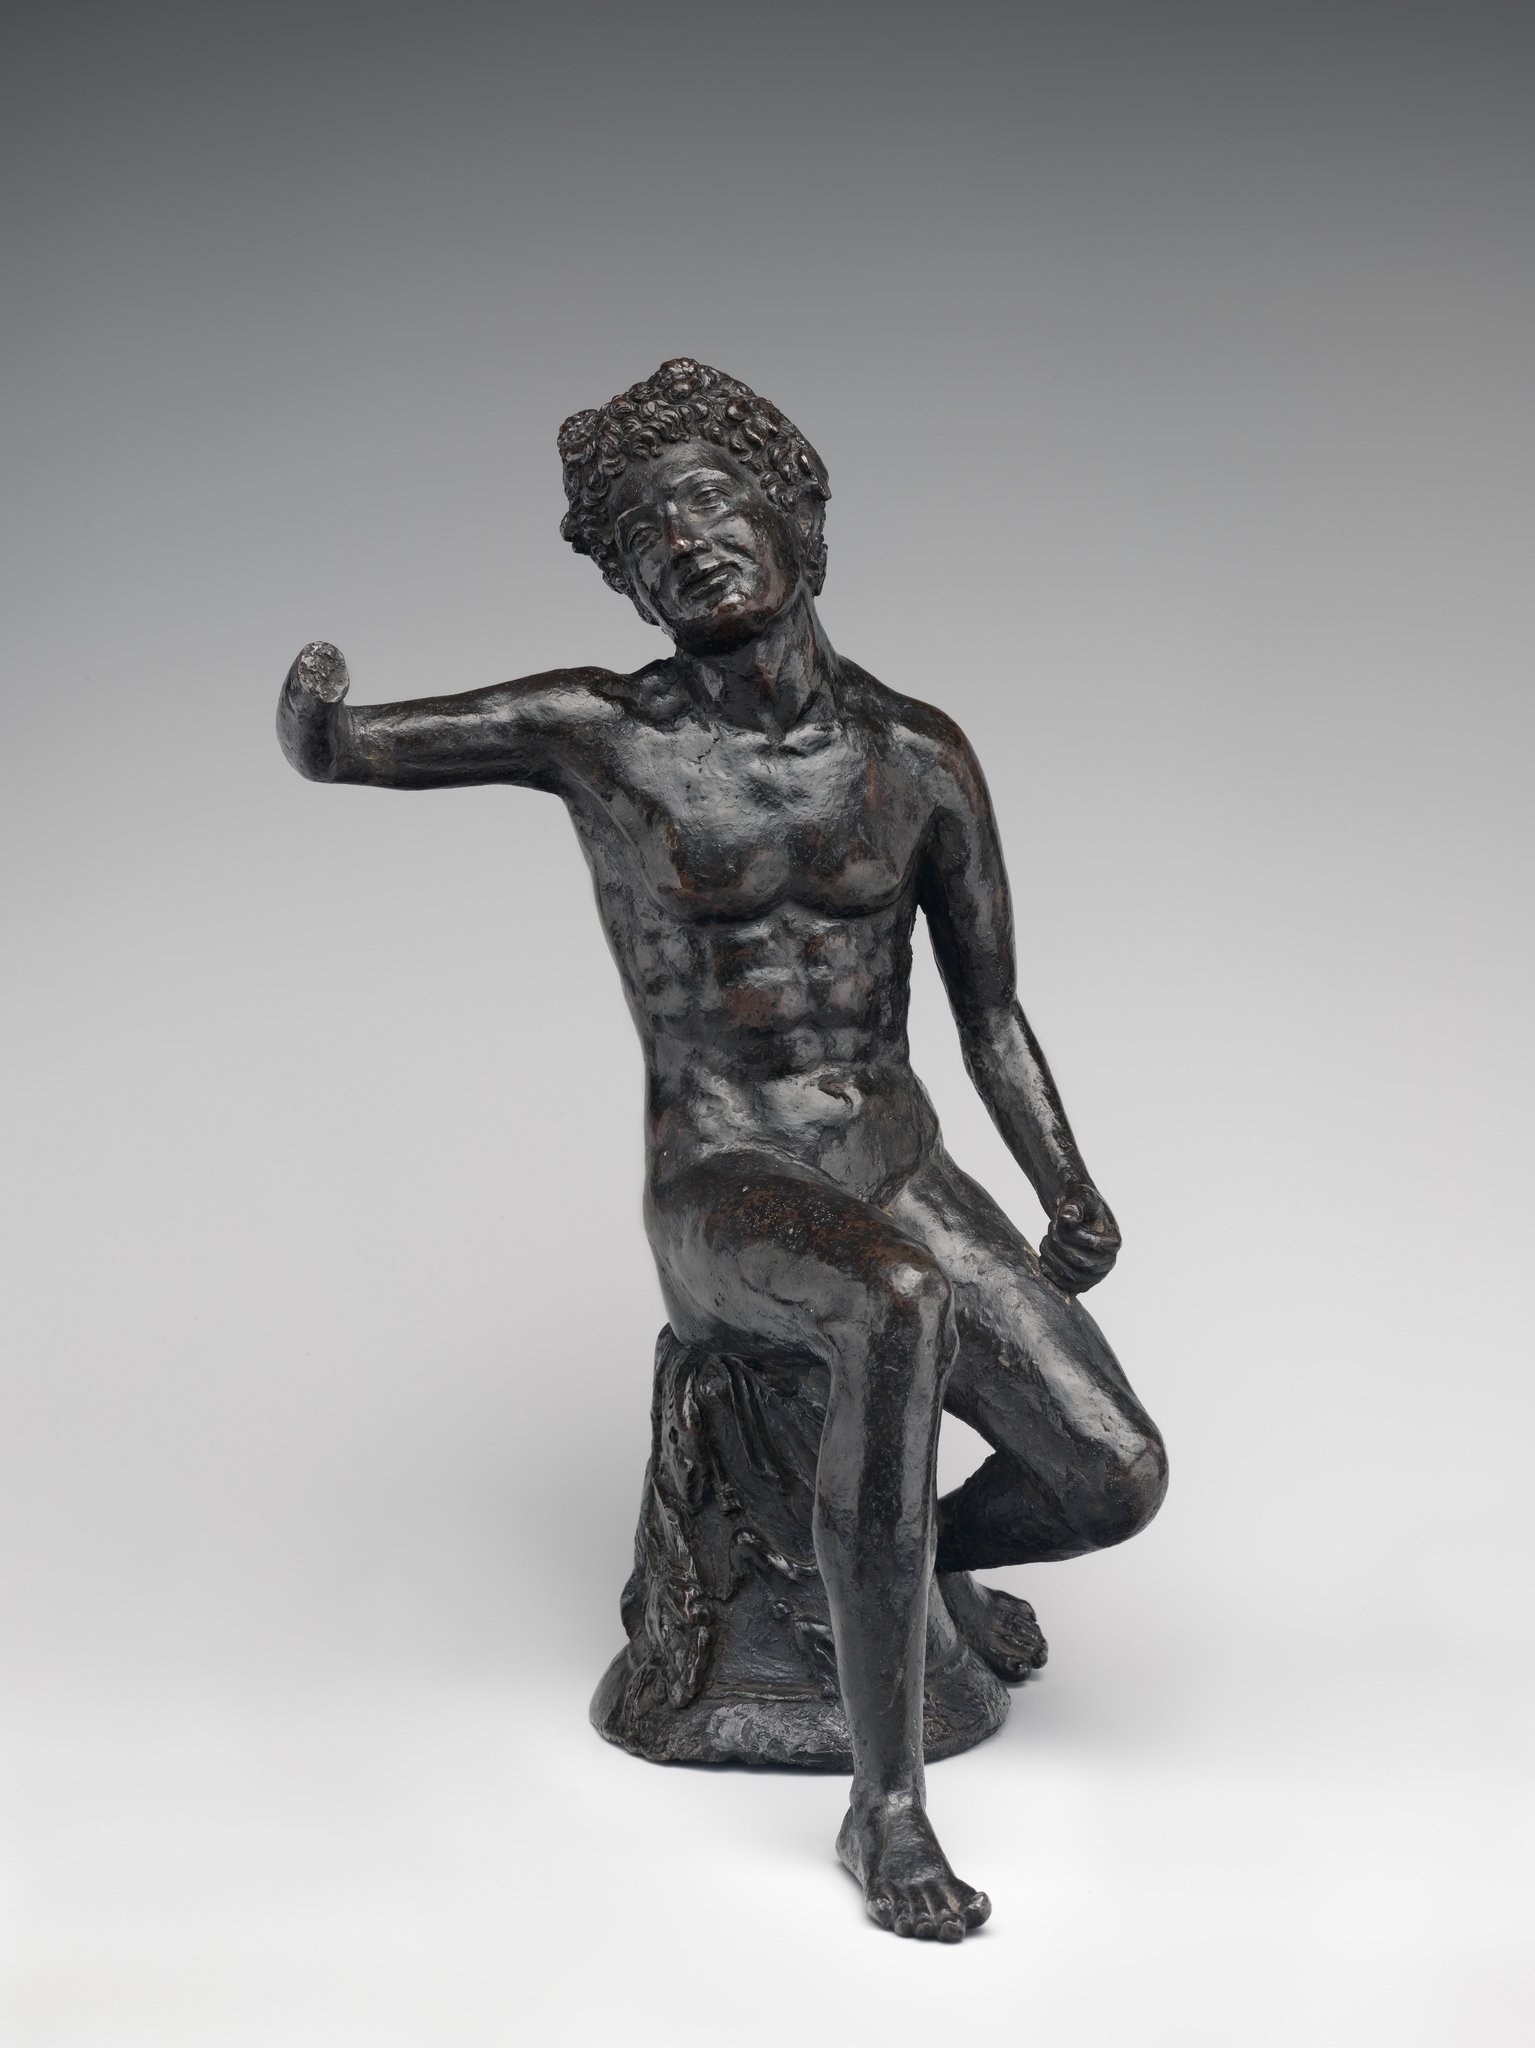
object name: statuette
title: Seated Faun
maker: andrea briosco, called riccio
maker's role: artist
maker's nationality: italian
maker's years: 1470-1532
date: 1540-1550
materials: bronze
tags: male nudes